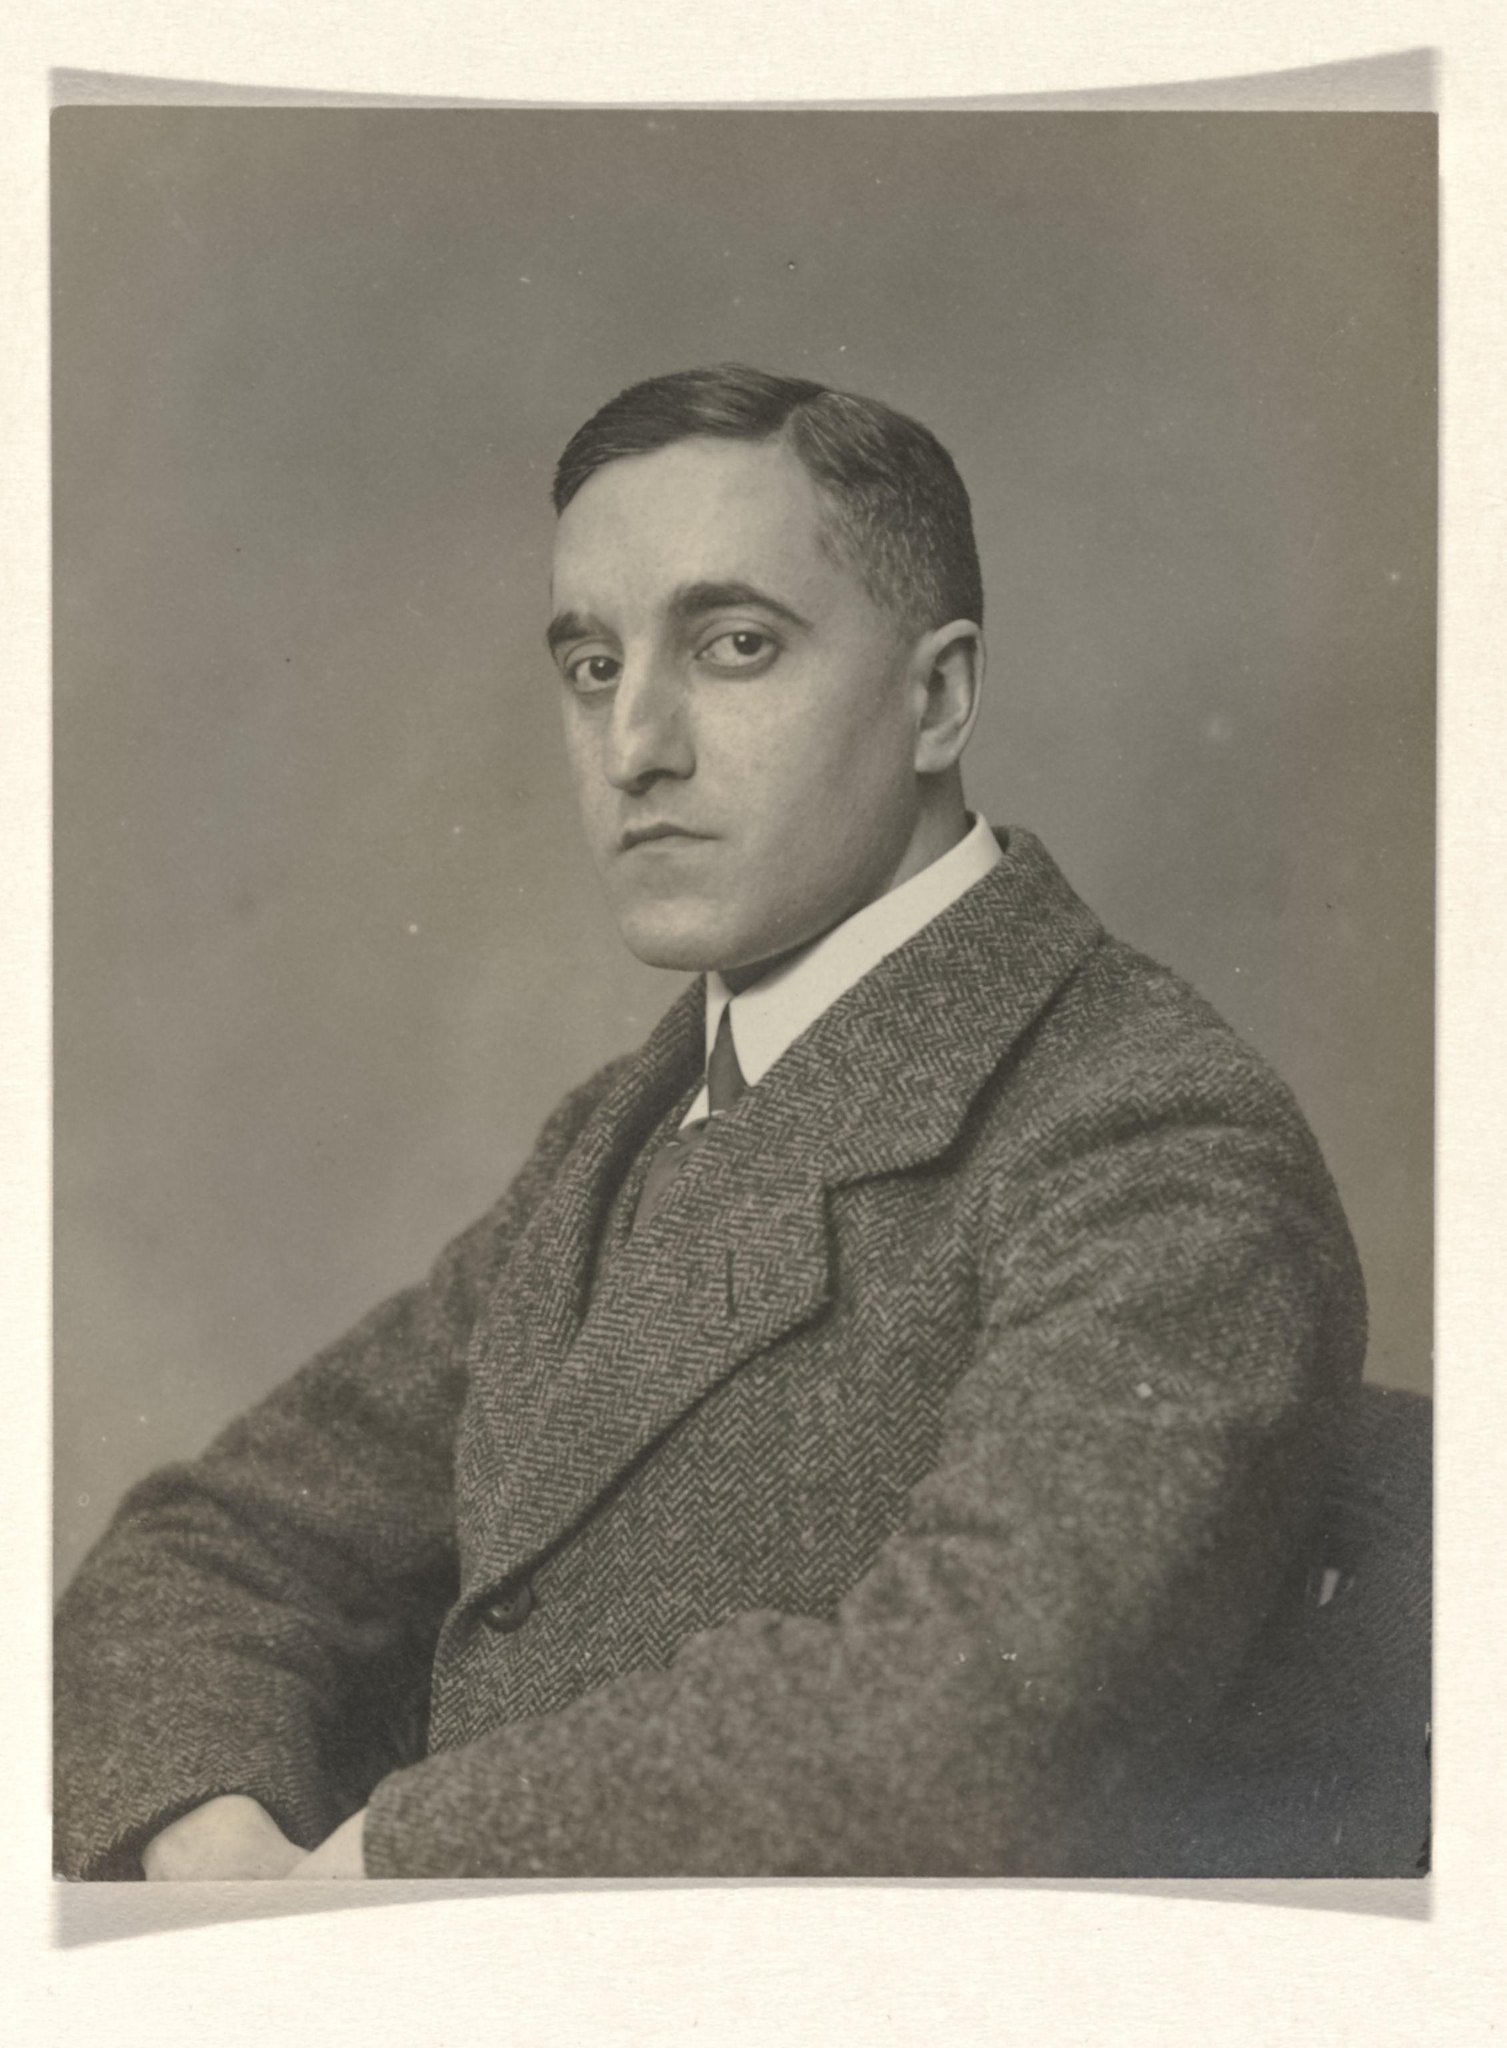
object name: photograph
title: Portret van Eugen Wachenheimer, 1906-1931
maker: Anonymous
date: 1906-1931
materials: photographic support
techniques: gelatin silver print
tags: eugen wachenheimer